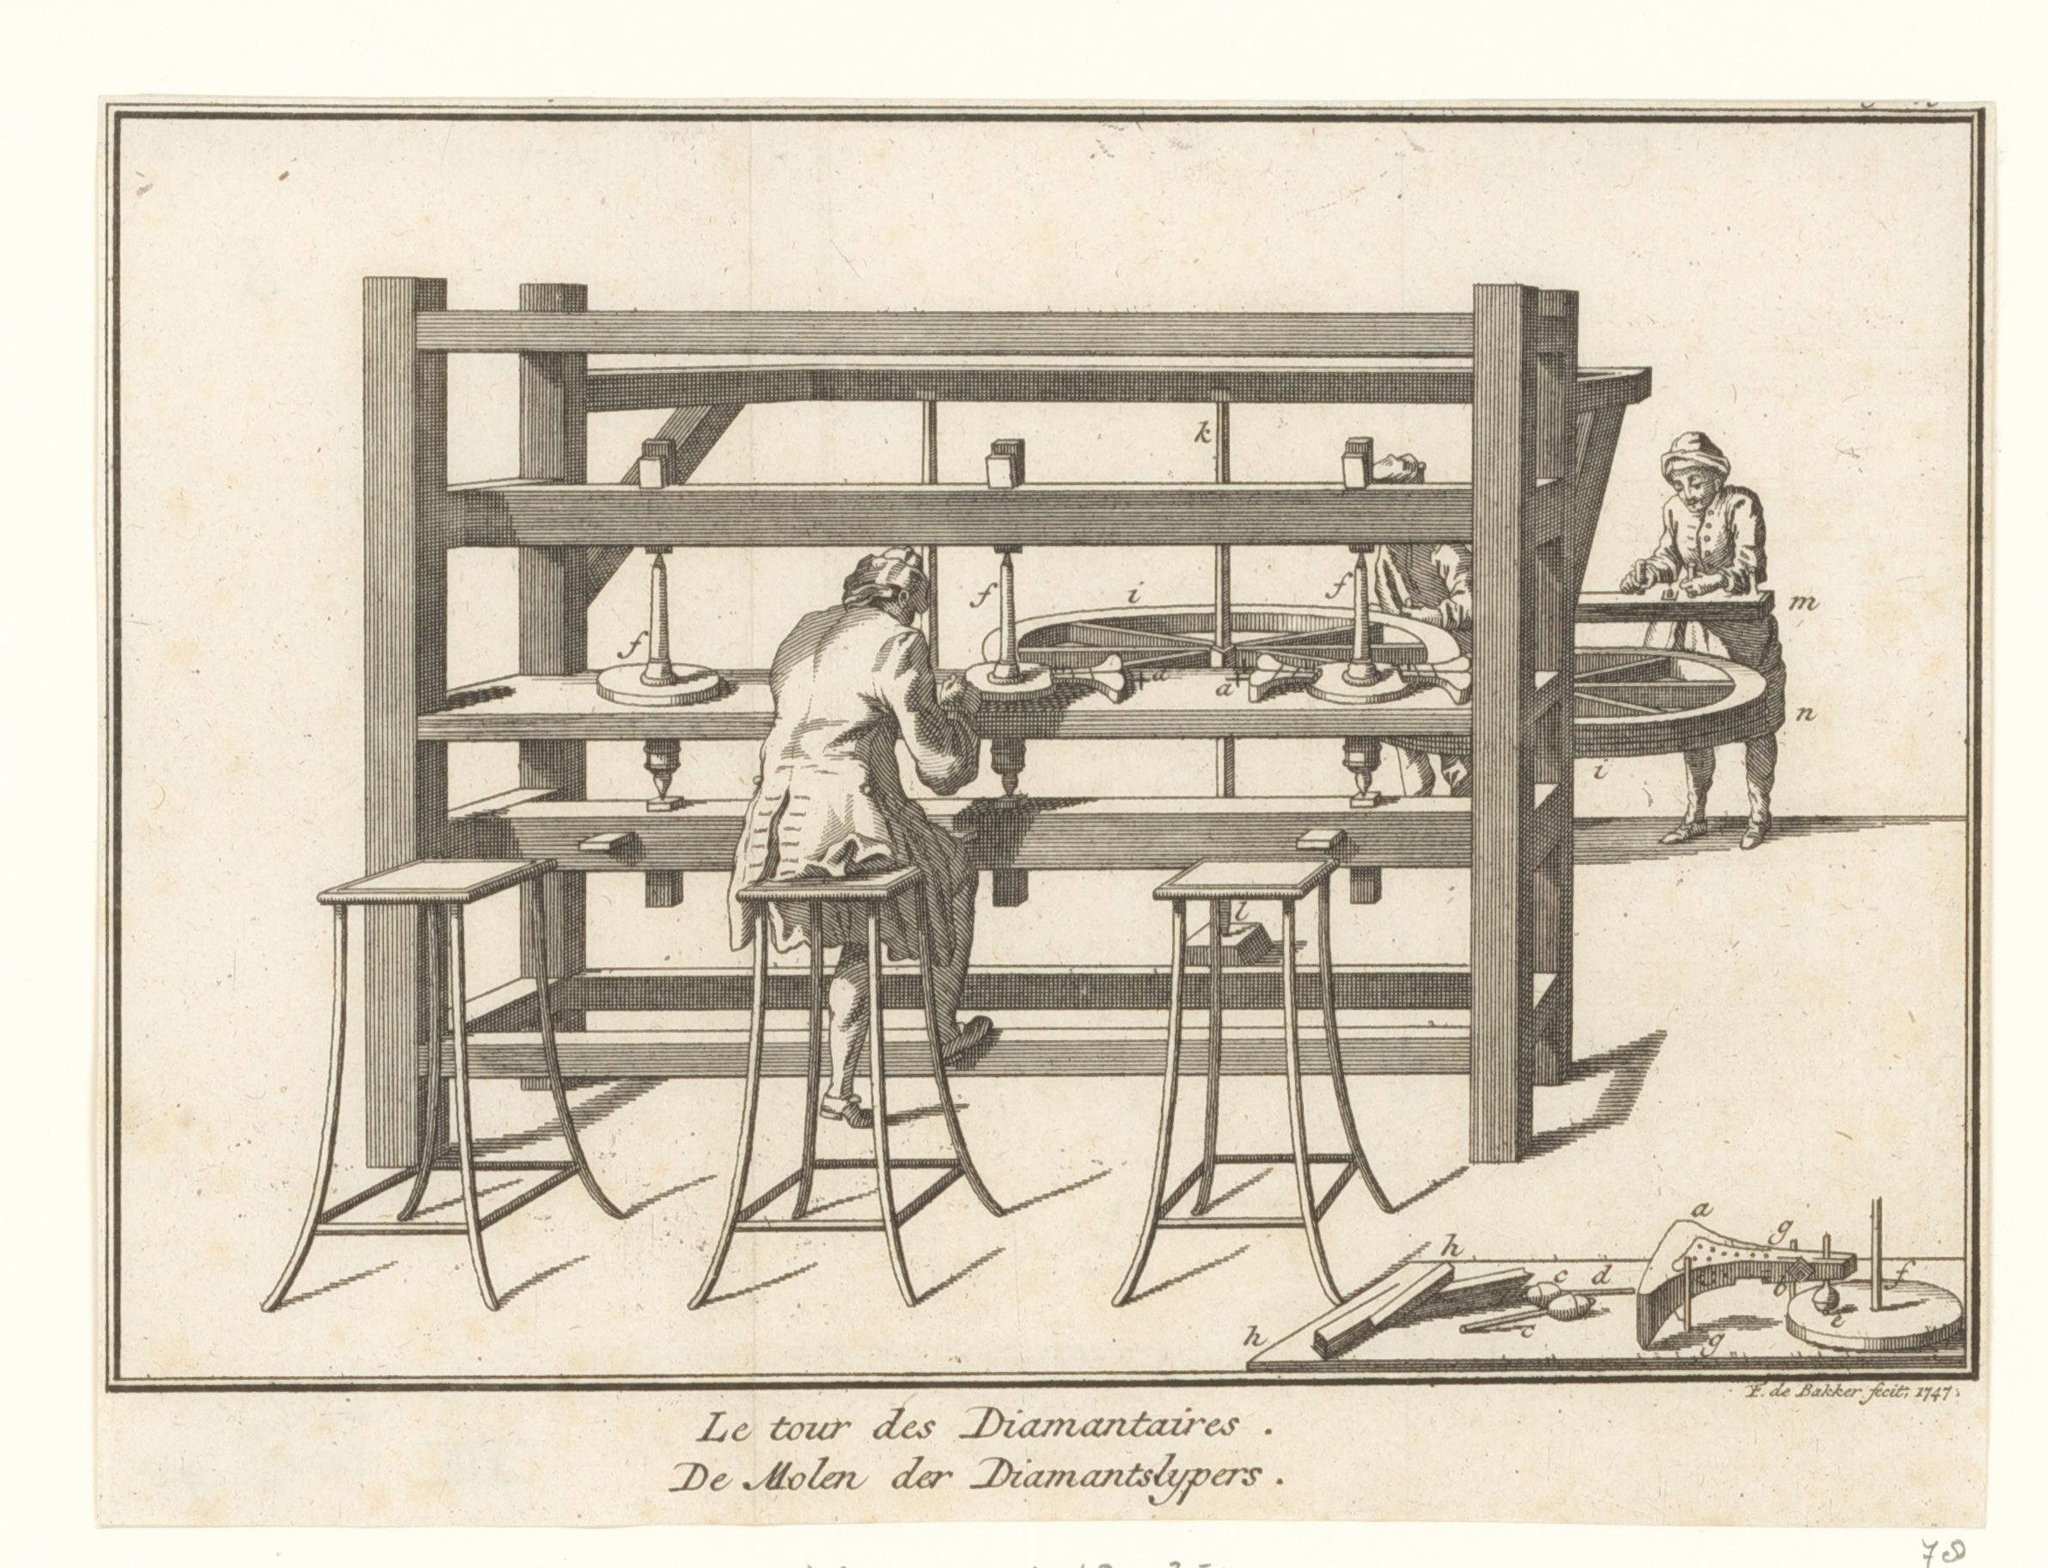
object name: print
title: Molen van de diamantslijpers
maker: frans de bakker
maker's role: print maker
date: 1747-1749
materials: paper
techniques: engraving, etching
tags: diamond polisher, diamond cutter, precious and semiprecious stones: diamond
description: Prent waarschijnlijk uit: Pluche, Noël-Antoine. Schouwtoneel der Natuur, of samenspraaken over de Bysonderheden der Natuurlyke Histori (...). [Vertaald uit het Frans door] Pieter le Clercq. 14 dln. Amsterdam: S. Schouten et al., 1749. dl. 13, na p. 64.